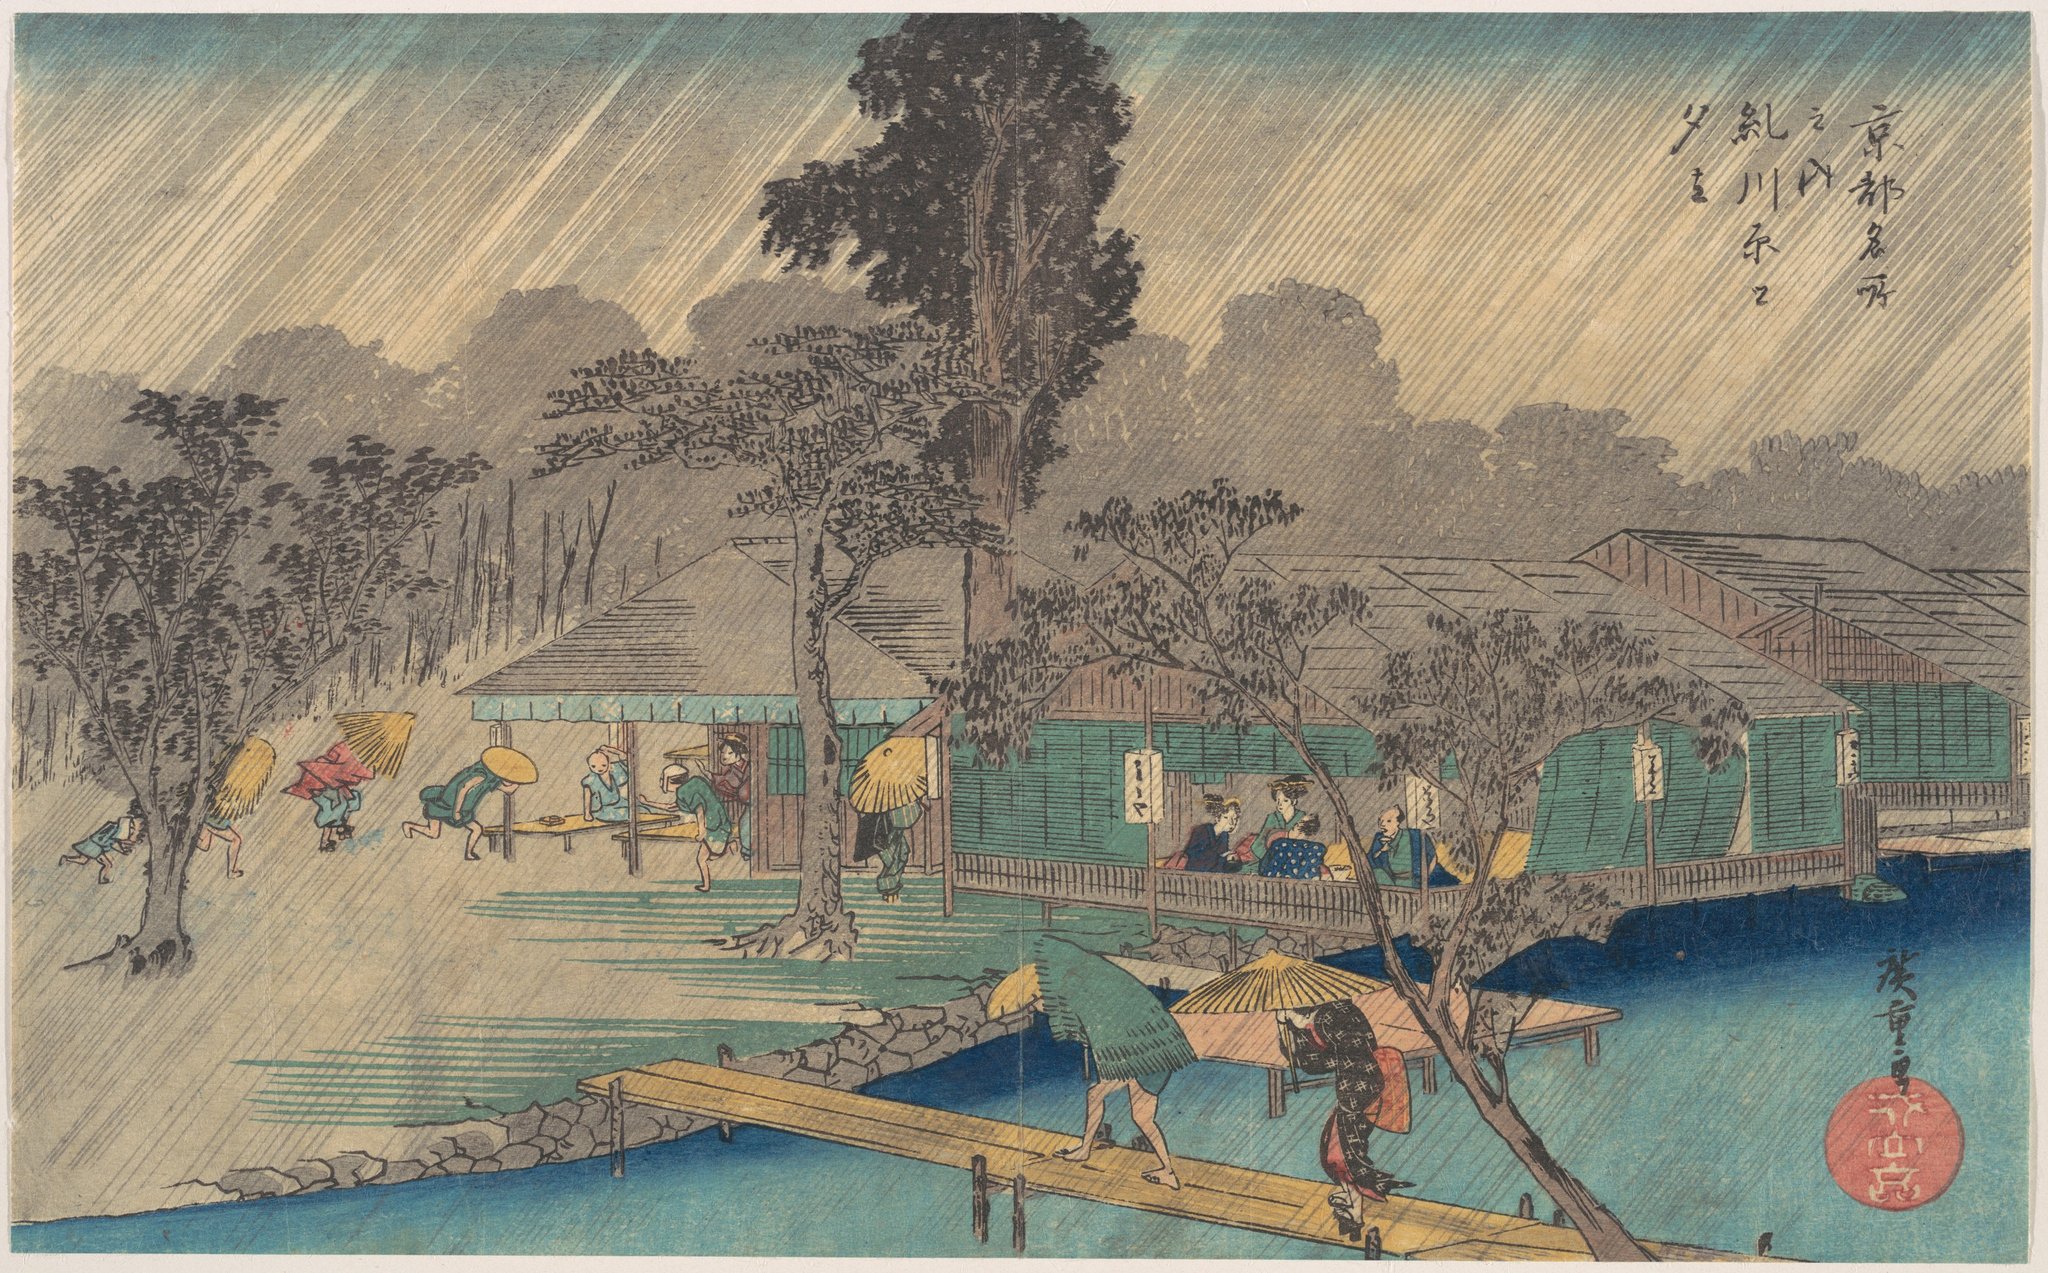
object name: print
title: Tea-houses on the Bank of the Tadasu River in a Shower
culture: japanese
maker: utagawa hiroshige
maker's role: artist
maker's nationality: japanese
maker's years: 1797-1858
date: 1797-1858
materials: ink, paper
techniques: woodblock print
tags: bridges,men,women,rain